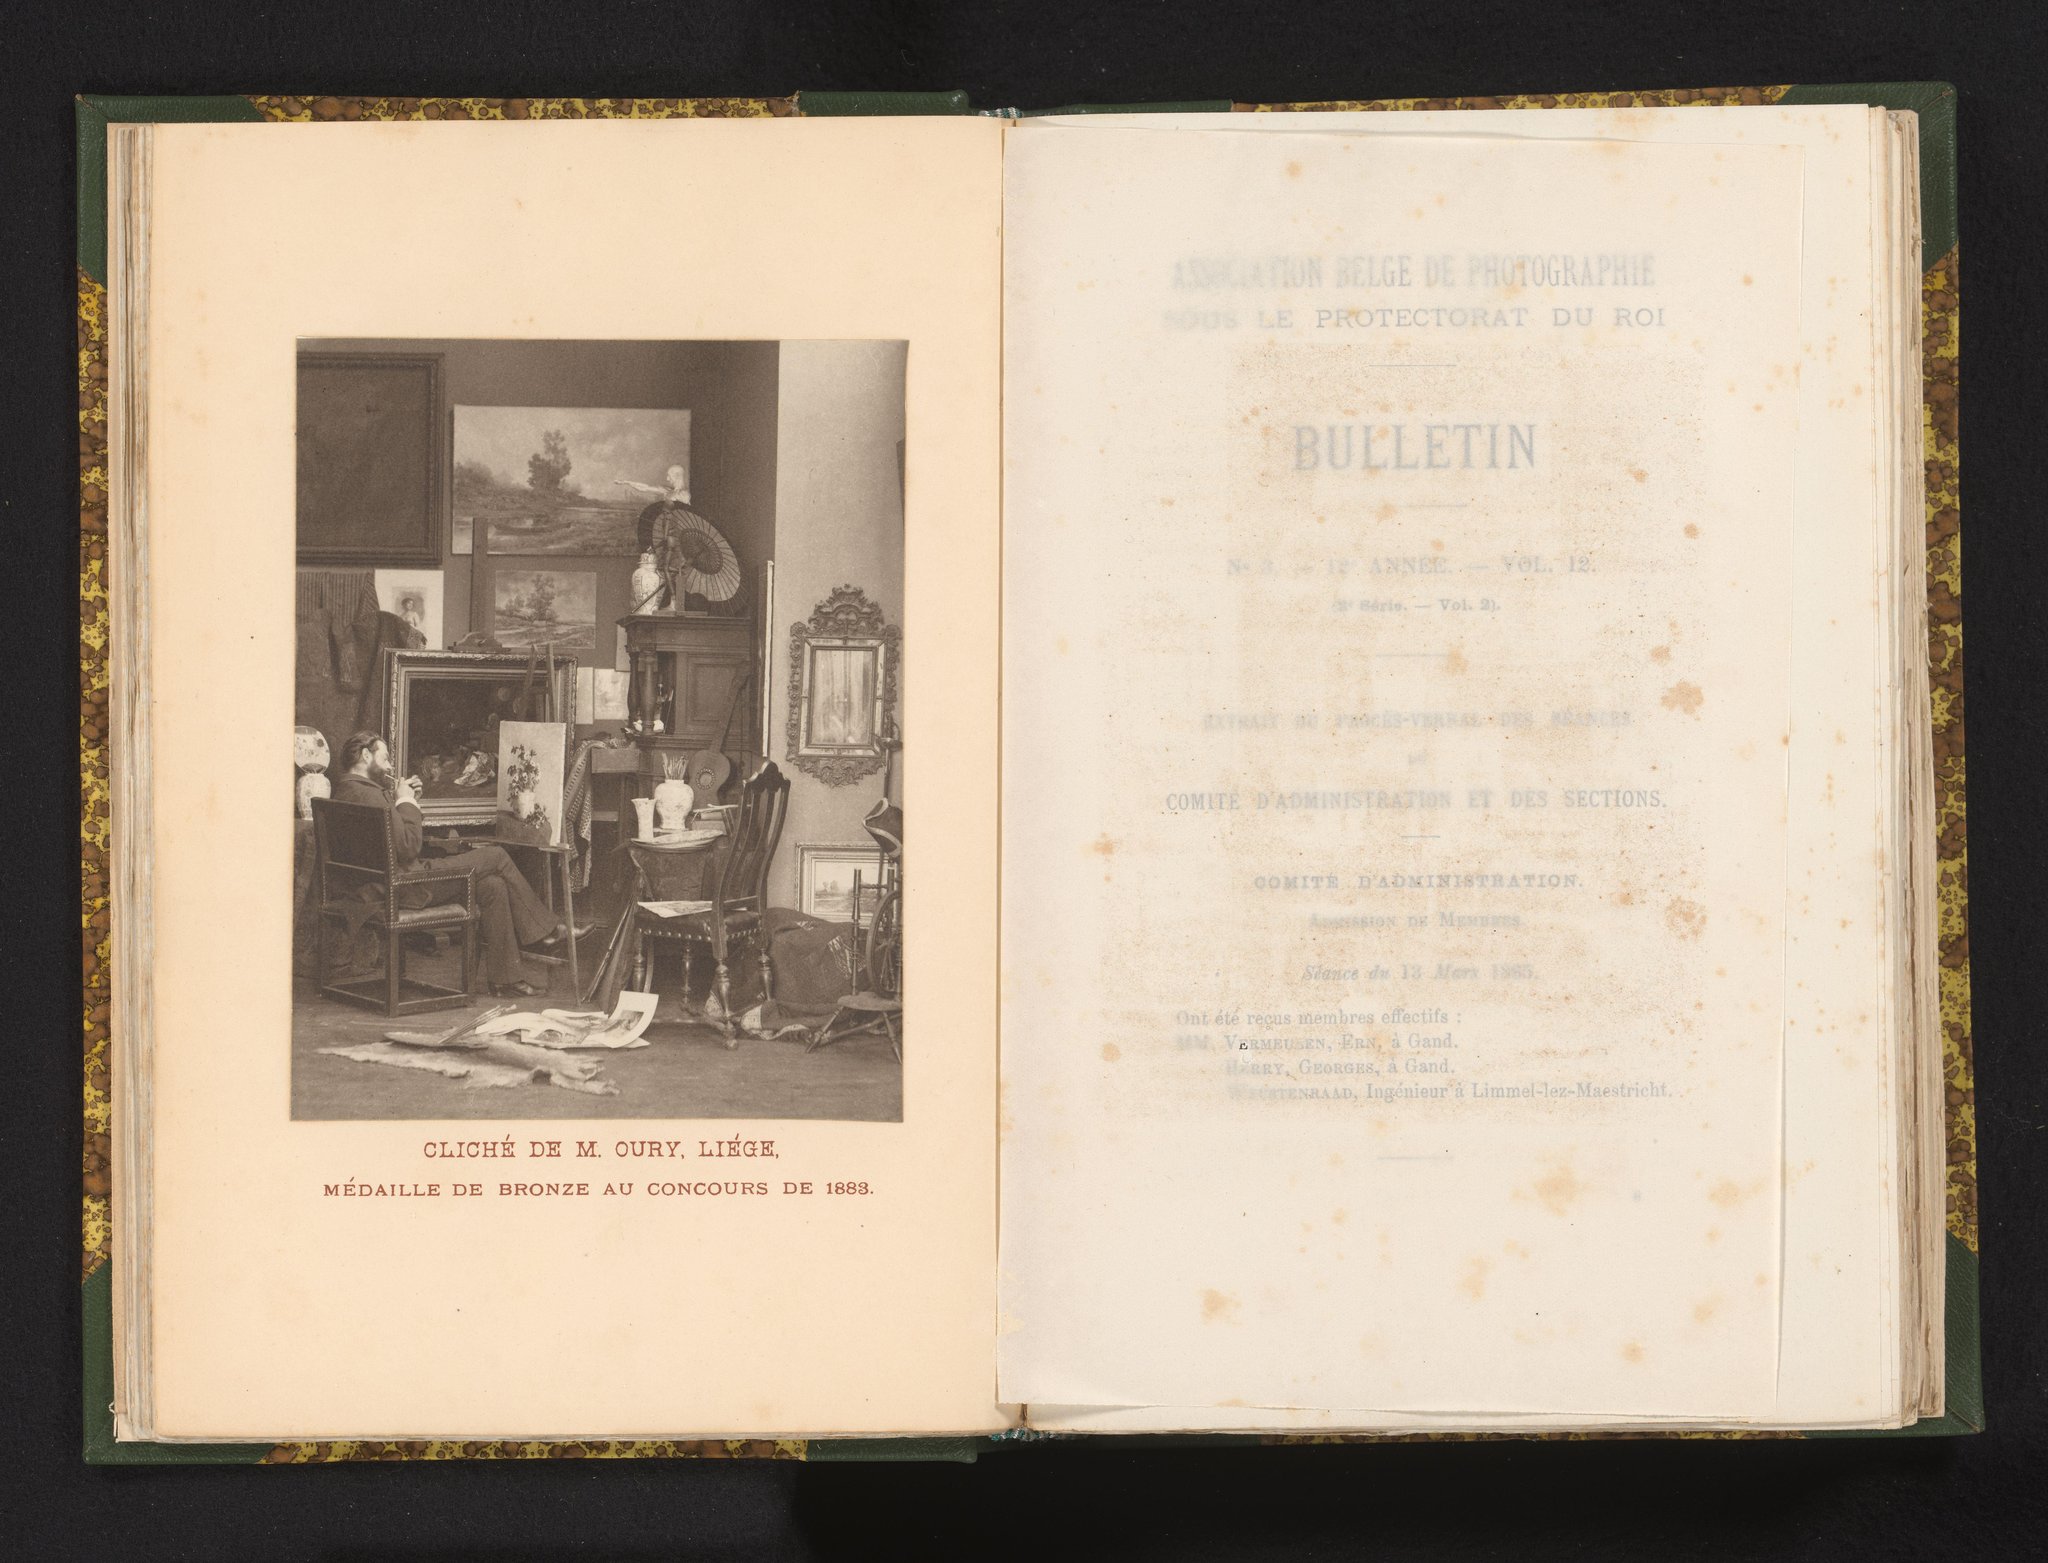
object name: photograph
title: Schilder zittend in een atelier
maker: guillaume oury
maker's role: amateurfotograaf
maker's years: 1840-1922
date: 1878-1883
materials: paper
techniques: platinum process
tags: workshop, studio ~ painter, painter at work, in his studio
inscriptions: inscription: ‘Médaille de bronze au concours de 1883.’